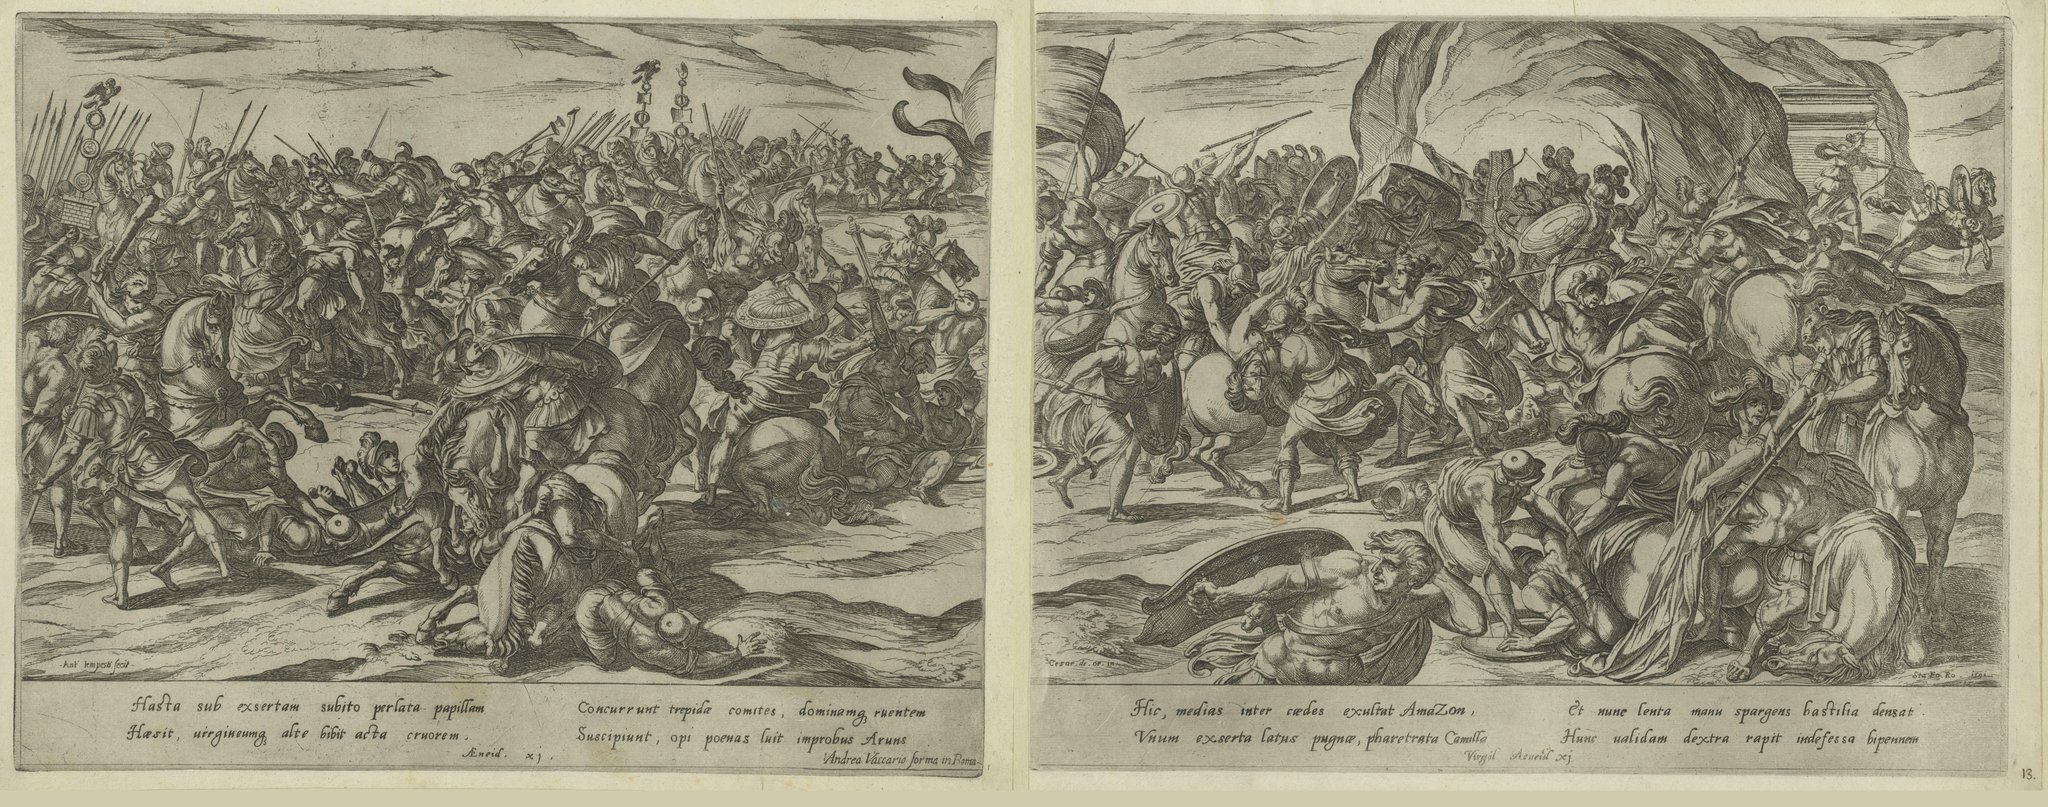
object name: print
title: De dood van Camillus in de strijd tussen Grieken en Romeinen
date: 1591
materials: paper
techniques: etching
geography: rome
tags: (story of) camilla - death, battle, the soldier; the soldier's life, warfare; military affairs (+ land forces)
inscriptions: collector's mark: Lugt 240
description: De dood van Camillus in een strijdgewoel van Griekse en Romeinse soldaten te paard. Vers in het Latijn in ondermarge.